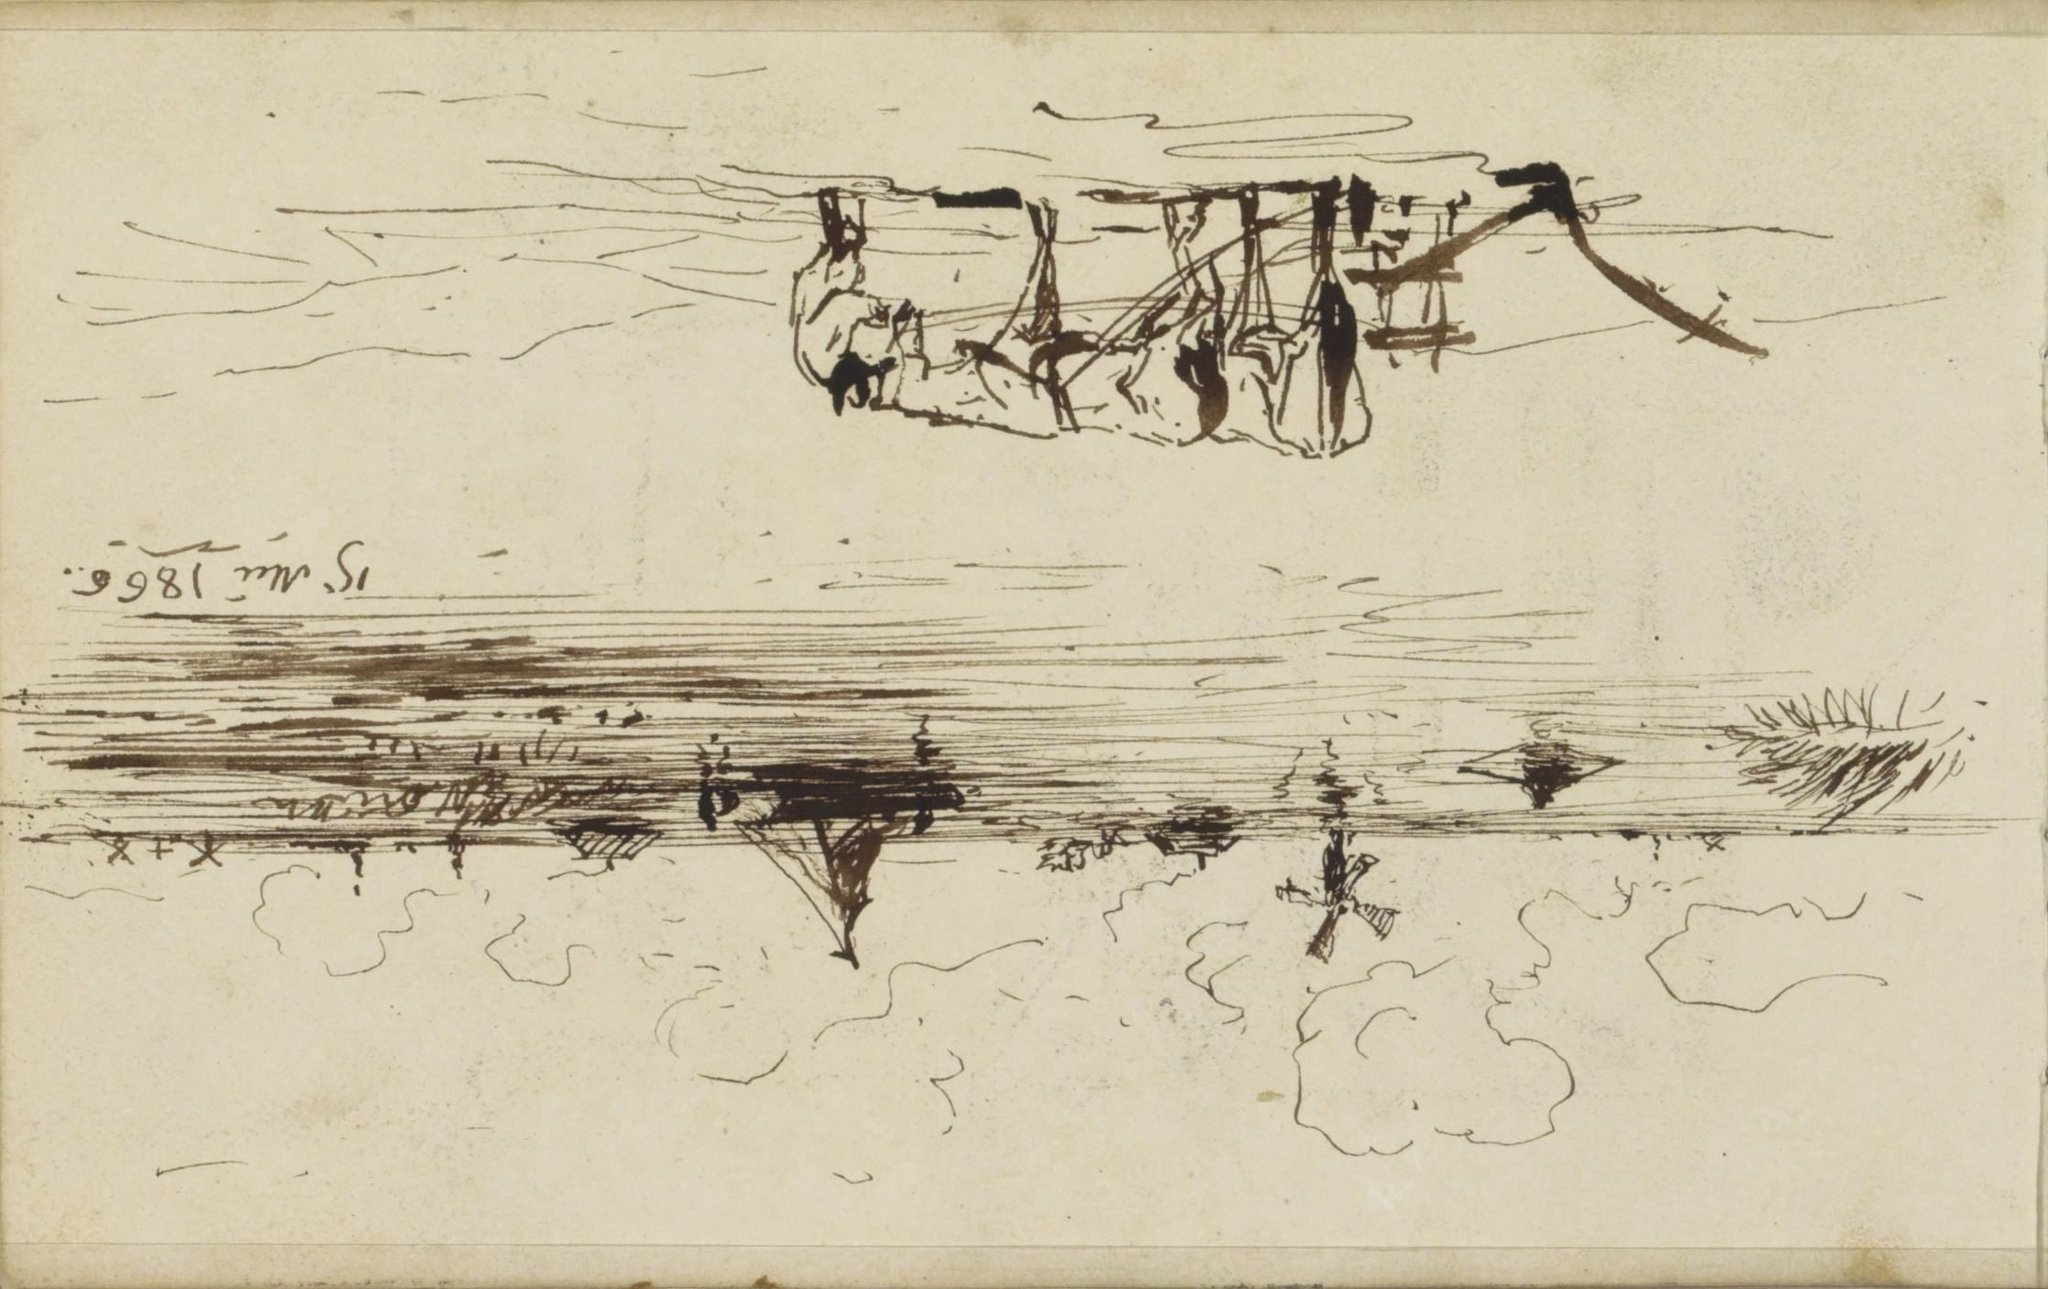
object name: sketchbook leaf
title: Paarden op het land en een waterlandschap met een molen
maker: johannes tavenraat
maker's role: draughtsman, painter, print maker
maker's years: 1809-1881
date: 1805-1866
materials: paper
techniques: pen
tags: sailing-ship, sailing-boat, landscapes with waters, waterscapes, seascapes (in the temperate zone), factories and mills in landscape, horse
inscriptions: date: ‘15 Mei 1866.’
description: Blad 35 verso uit een schetsboek met 37 bladen.